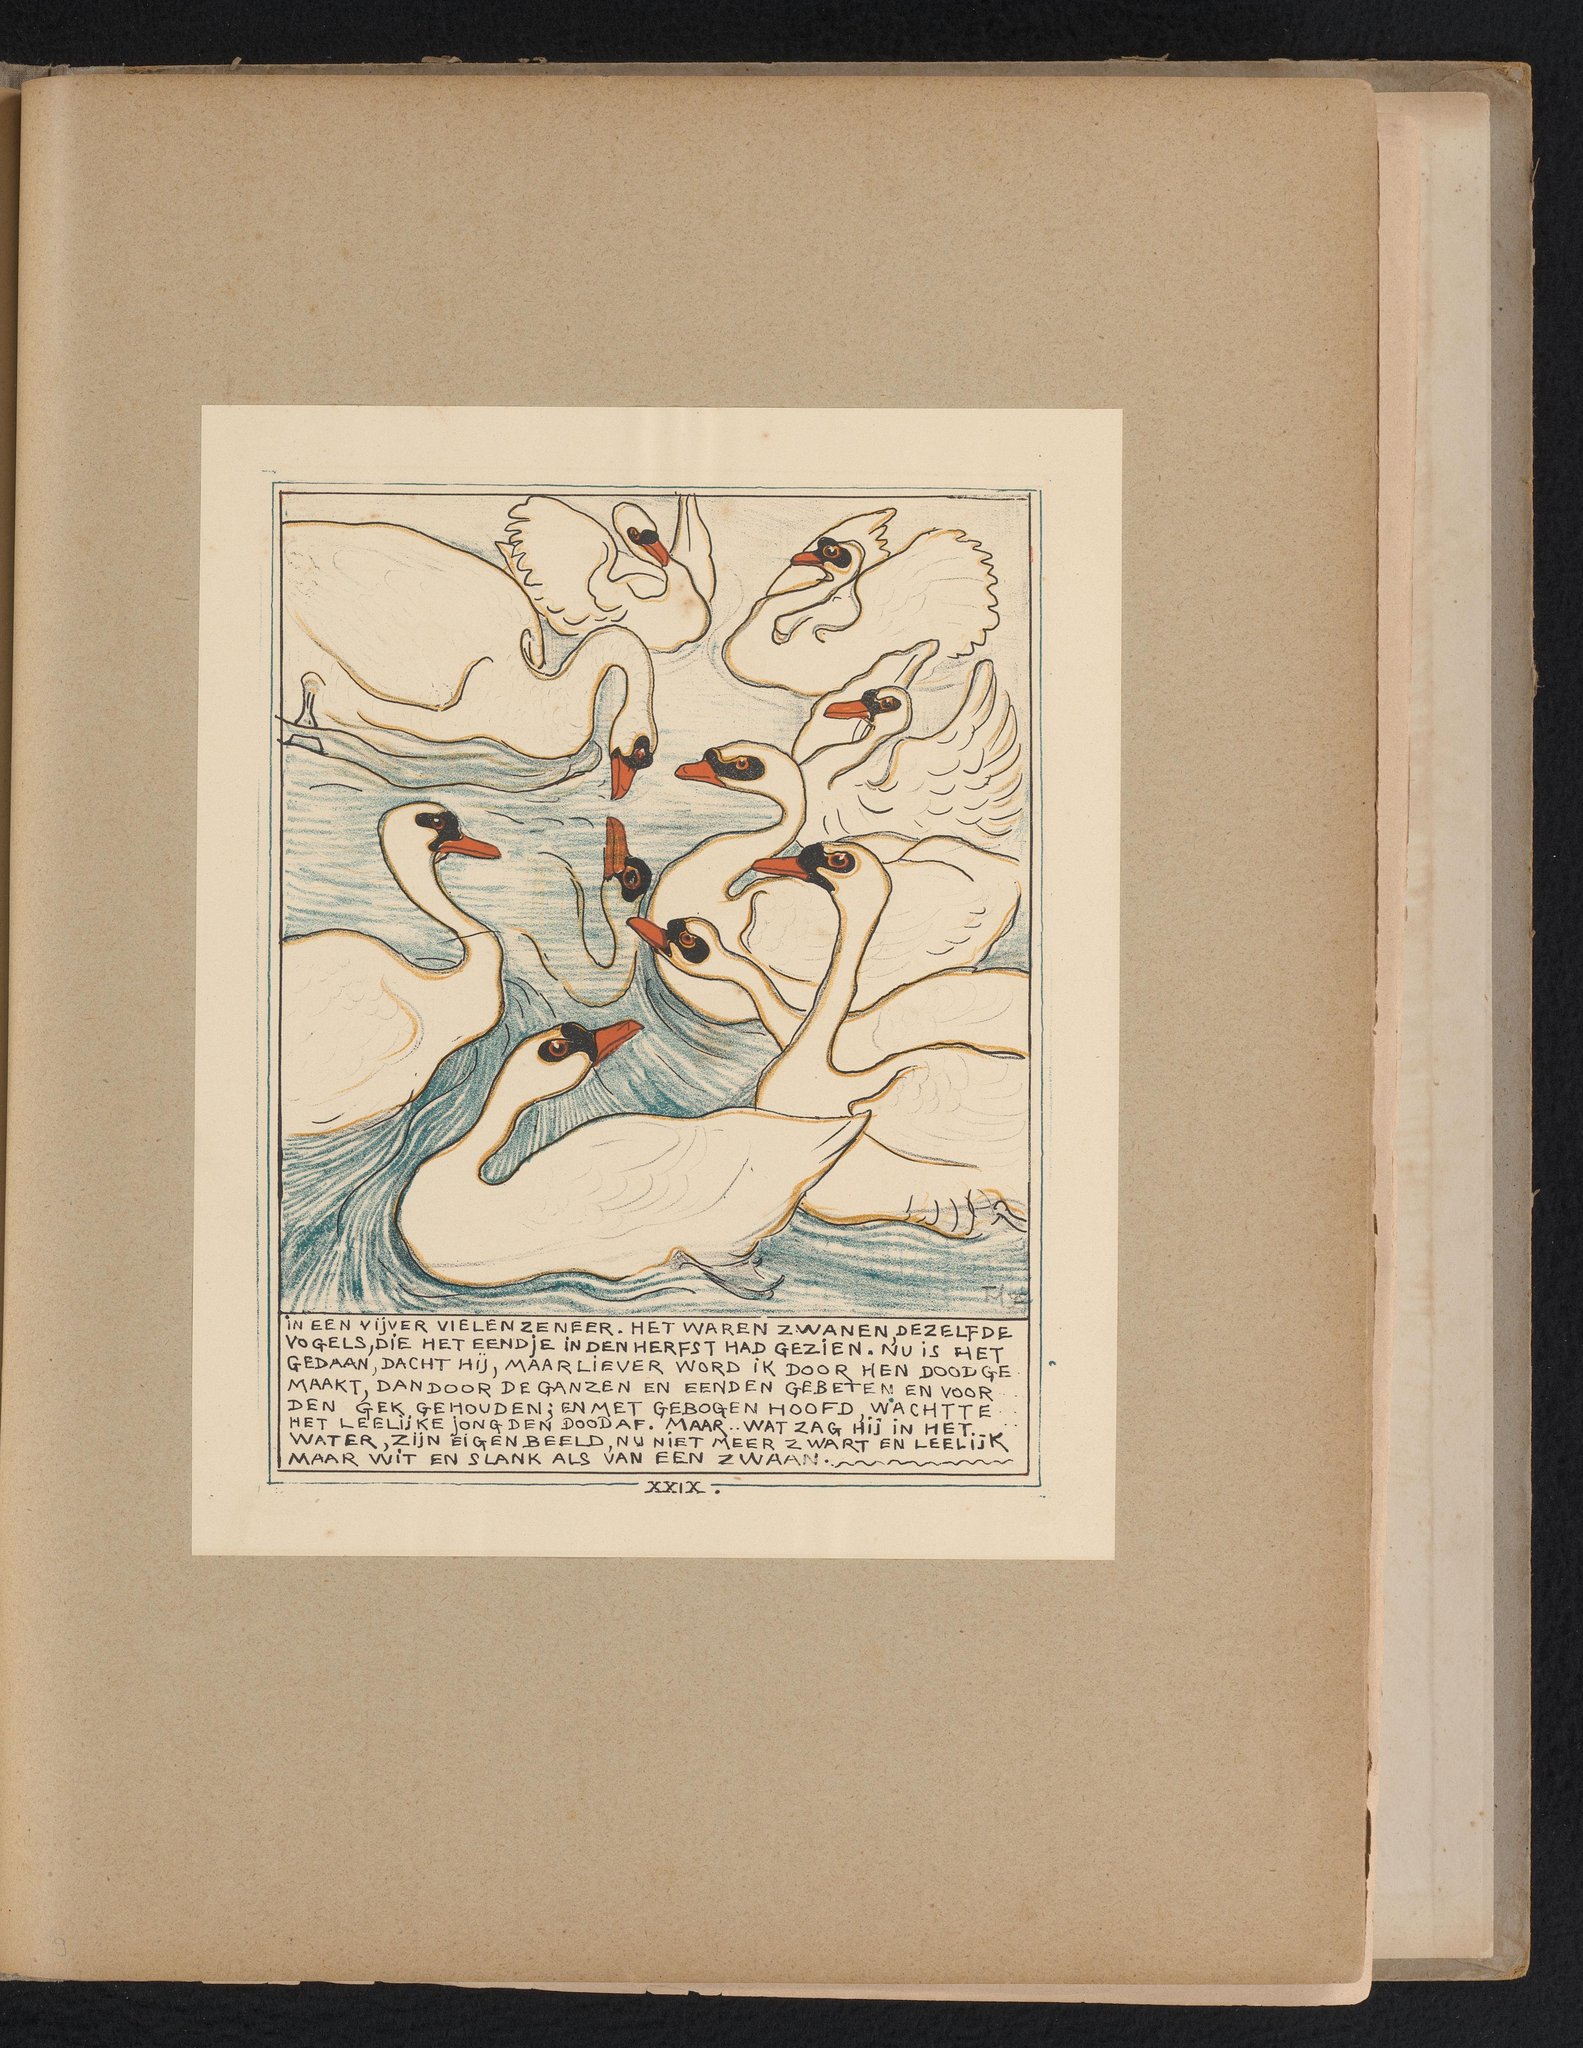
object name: album leaf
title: Het leelijke jonge eendje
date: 1893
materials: paper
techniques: lithograph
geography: amsterdam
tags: water-birds: swan, reflection (in a mirror)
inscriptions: date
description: Deze prent maakt deel uit van een album.